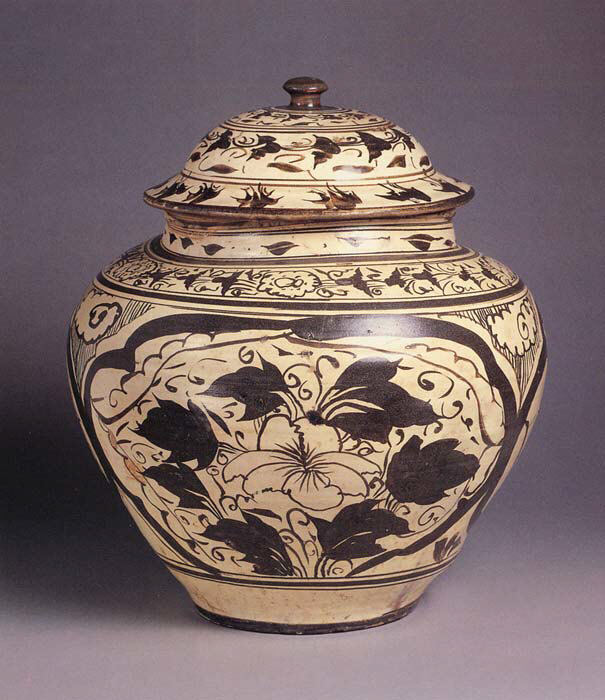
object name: jar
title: Covered Jar (Guan shape)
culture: chinese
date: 1301-1400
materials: stoneware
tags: flowers,leaves